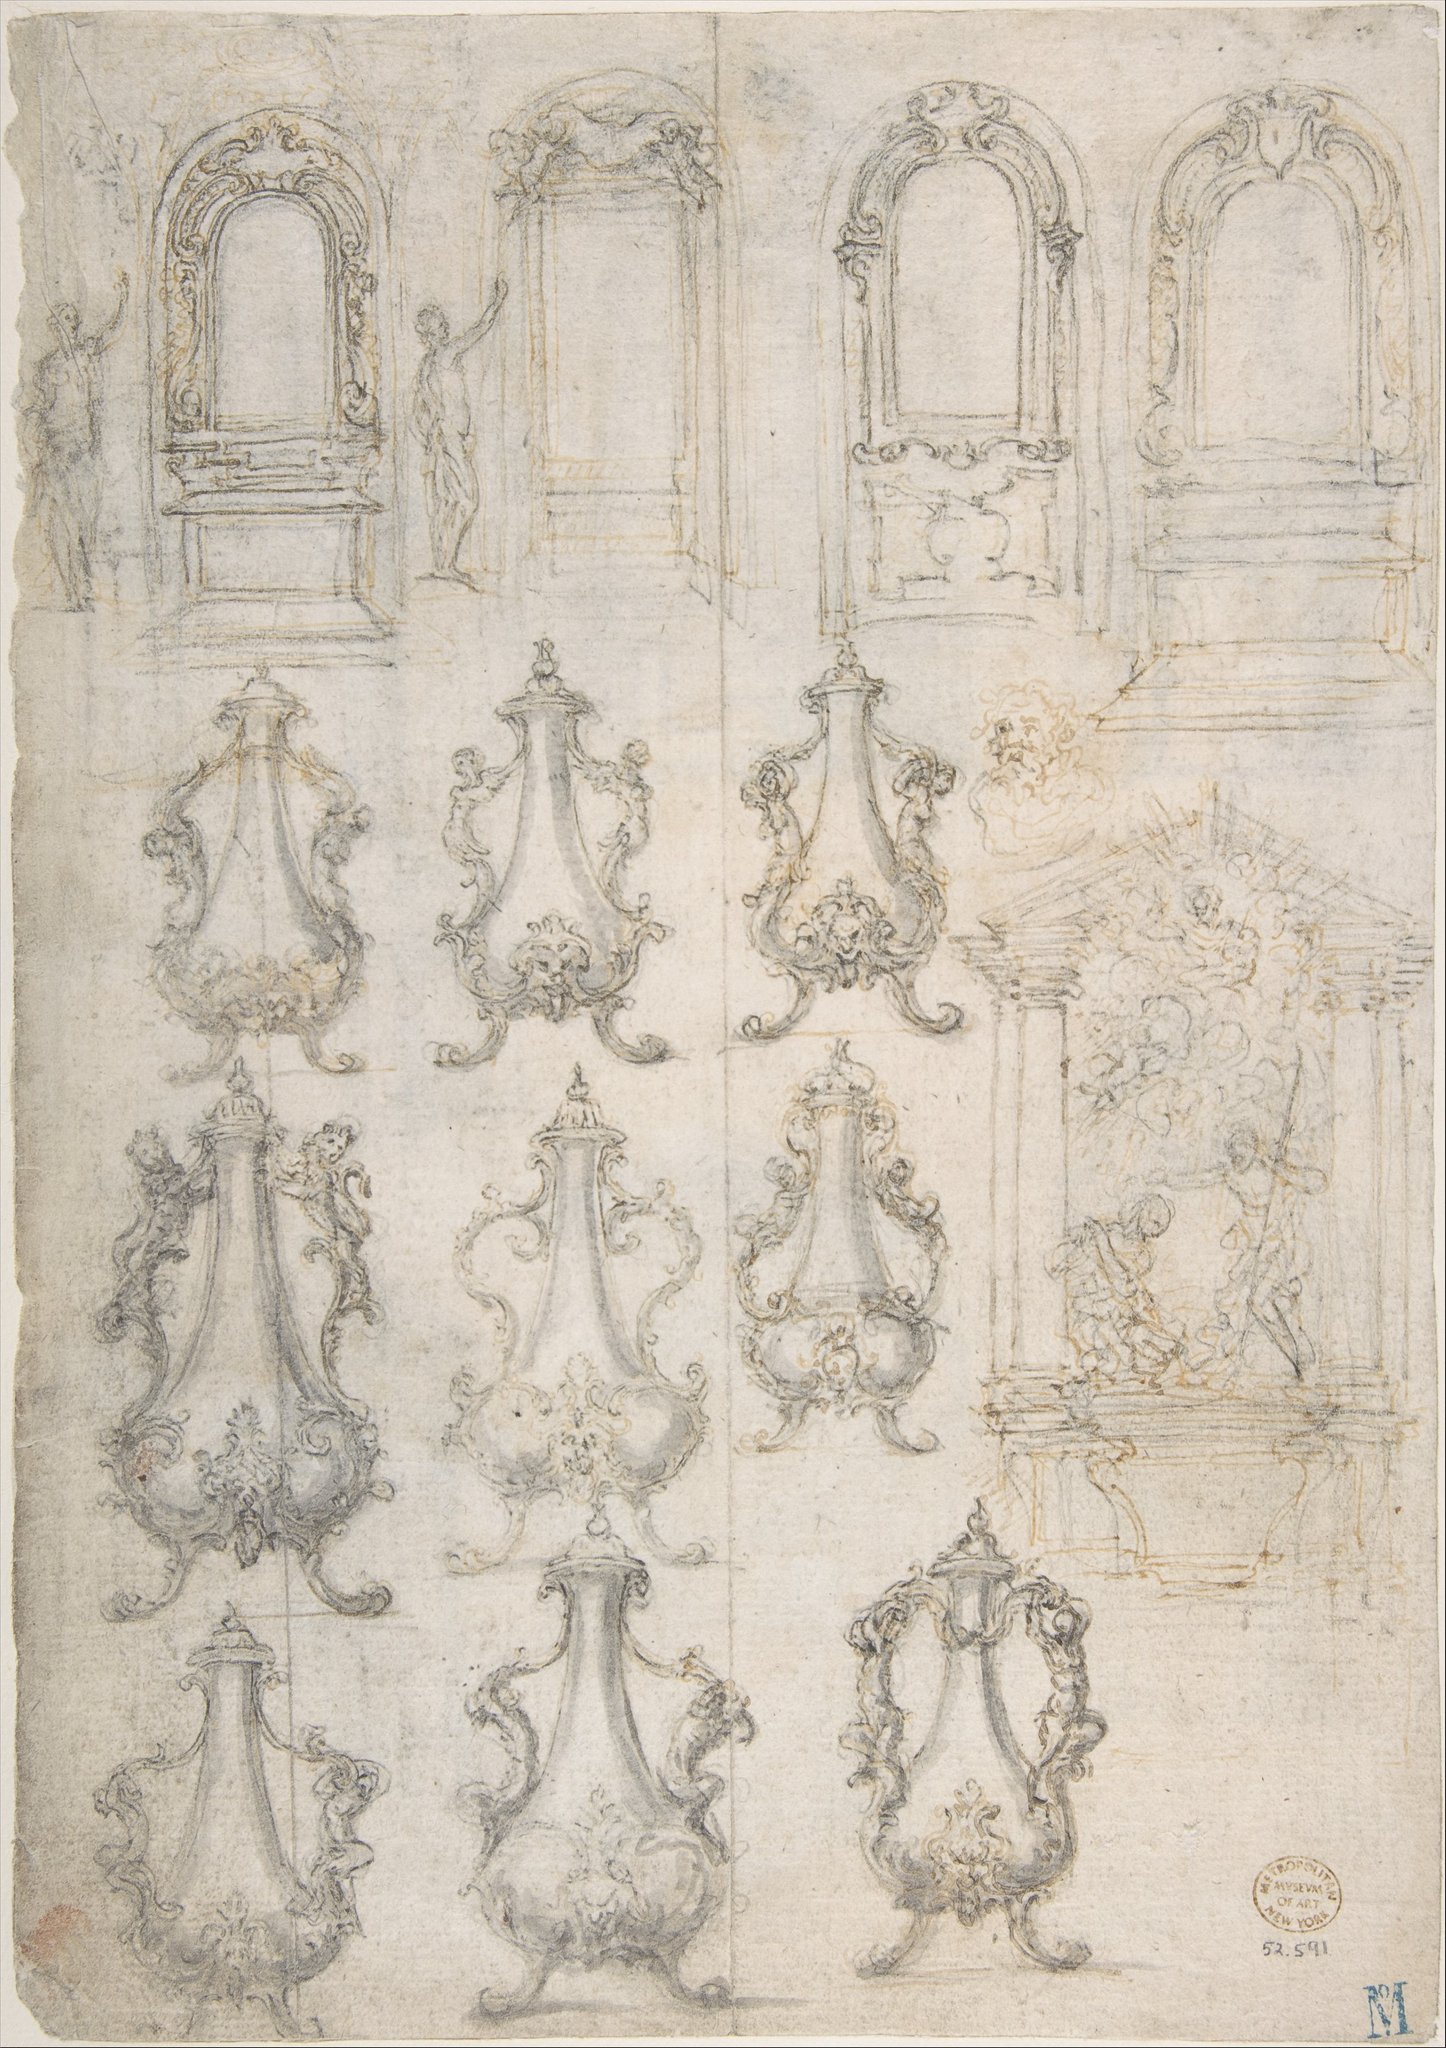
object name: drawing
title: Studies for Coffee Urns, Arched-top Altars, and an Altar Project for the Baptistery of Florence Cathedral (recto); Studies for Chapels and Portals (verso)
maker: giovanni battista foggini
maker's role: artist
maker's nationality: italian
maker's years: 1652-1725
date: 1652-1725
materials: chalk, ink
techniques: brush, pen, wash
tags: human figures,altars,urns